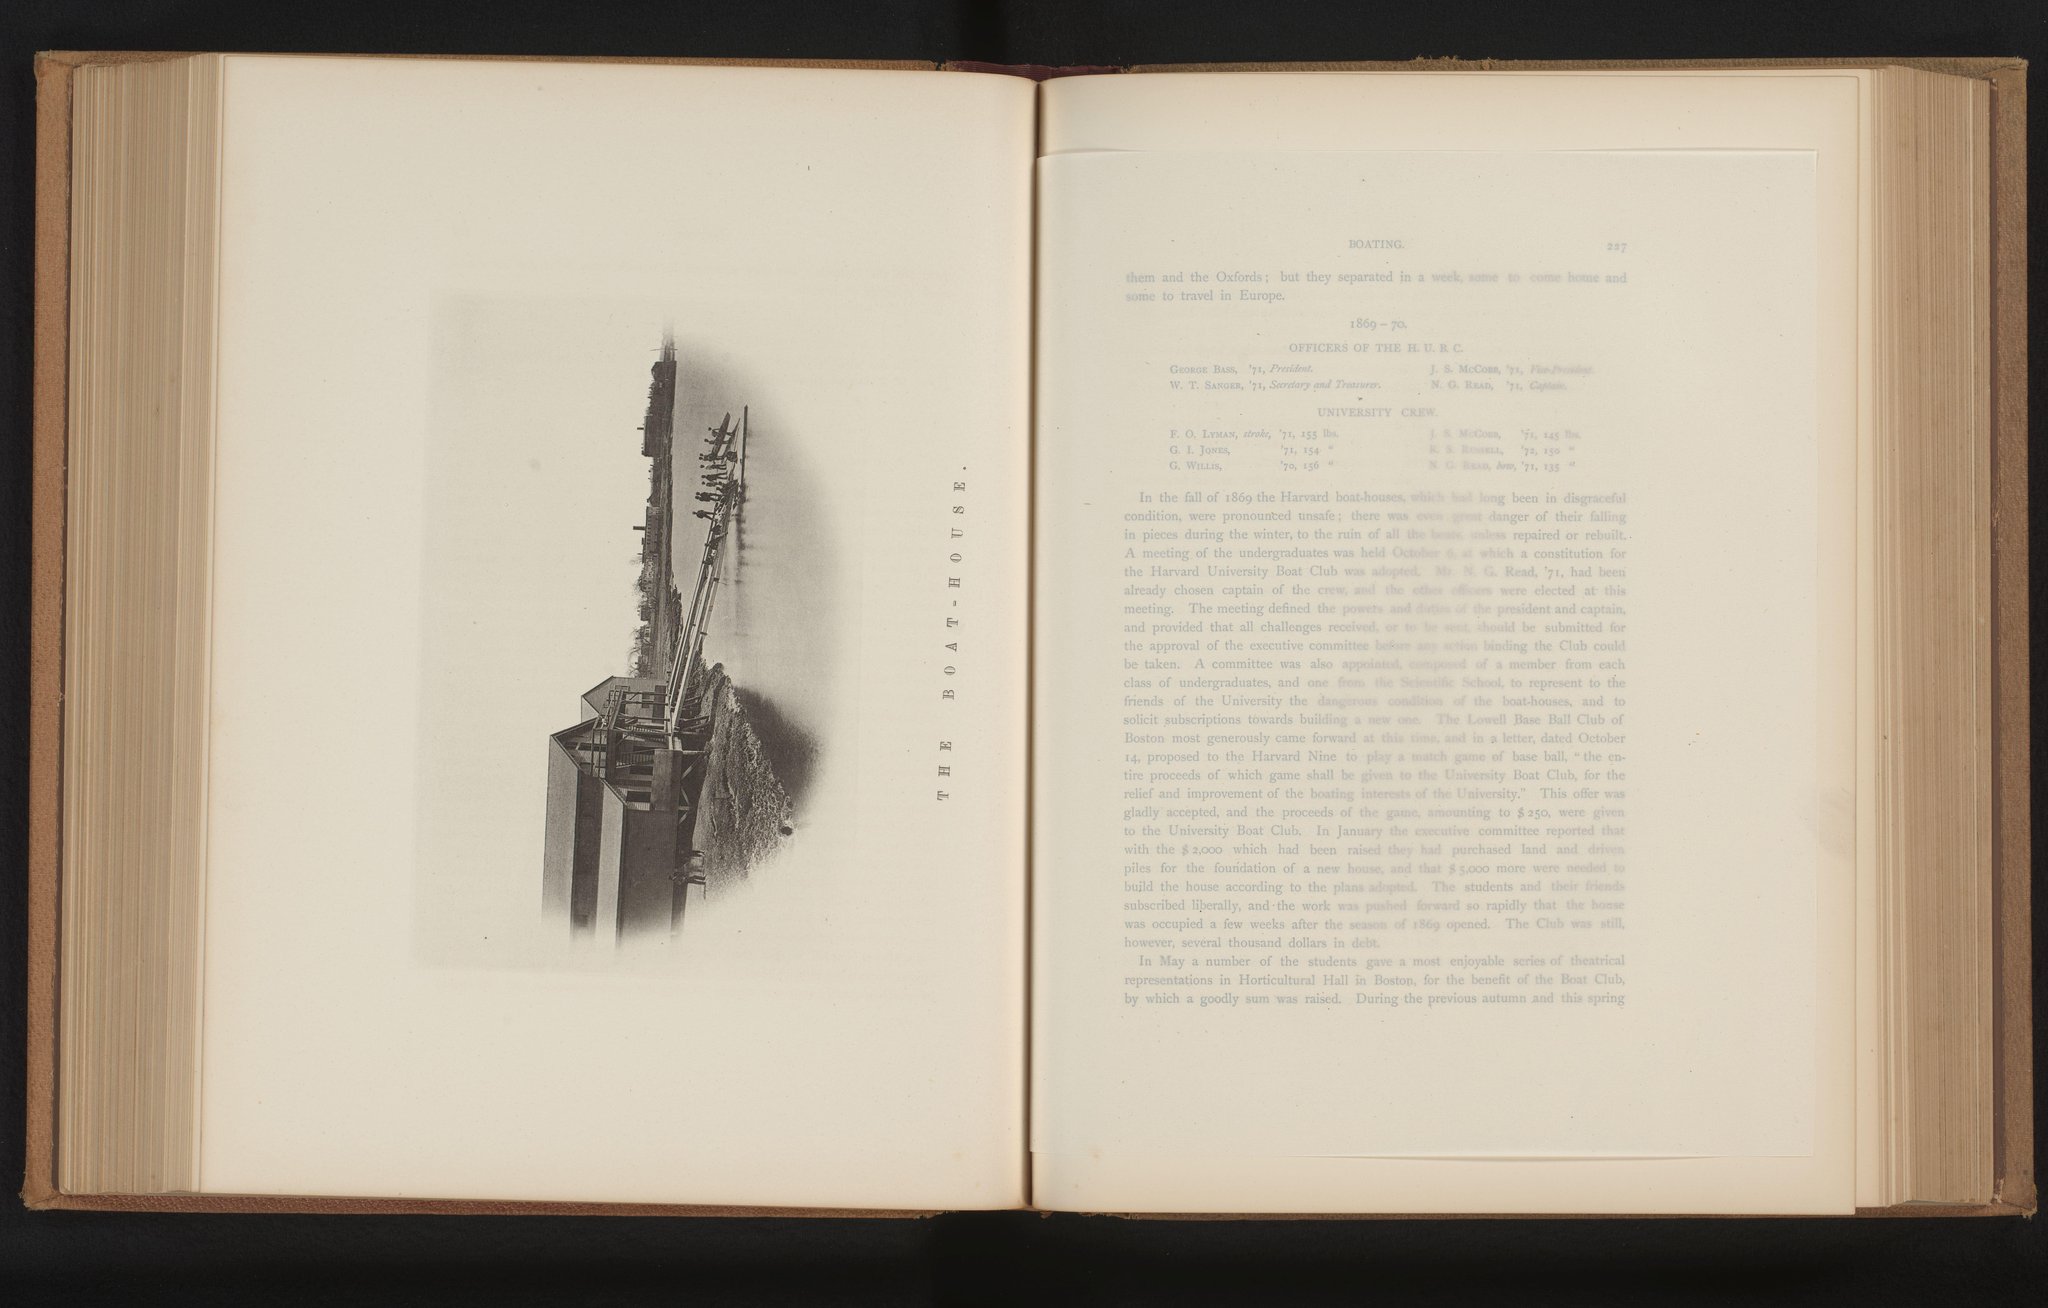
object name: page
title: The Boat-House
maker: Anonymous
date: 1870-1875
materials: paper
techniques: photograph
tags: boat-house, shed (+ four persons or more ~ traffic and transport), university building, college